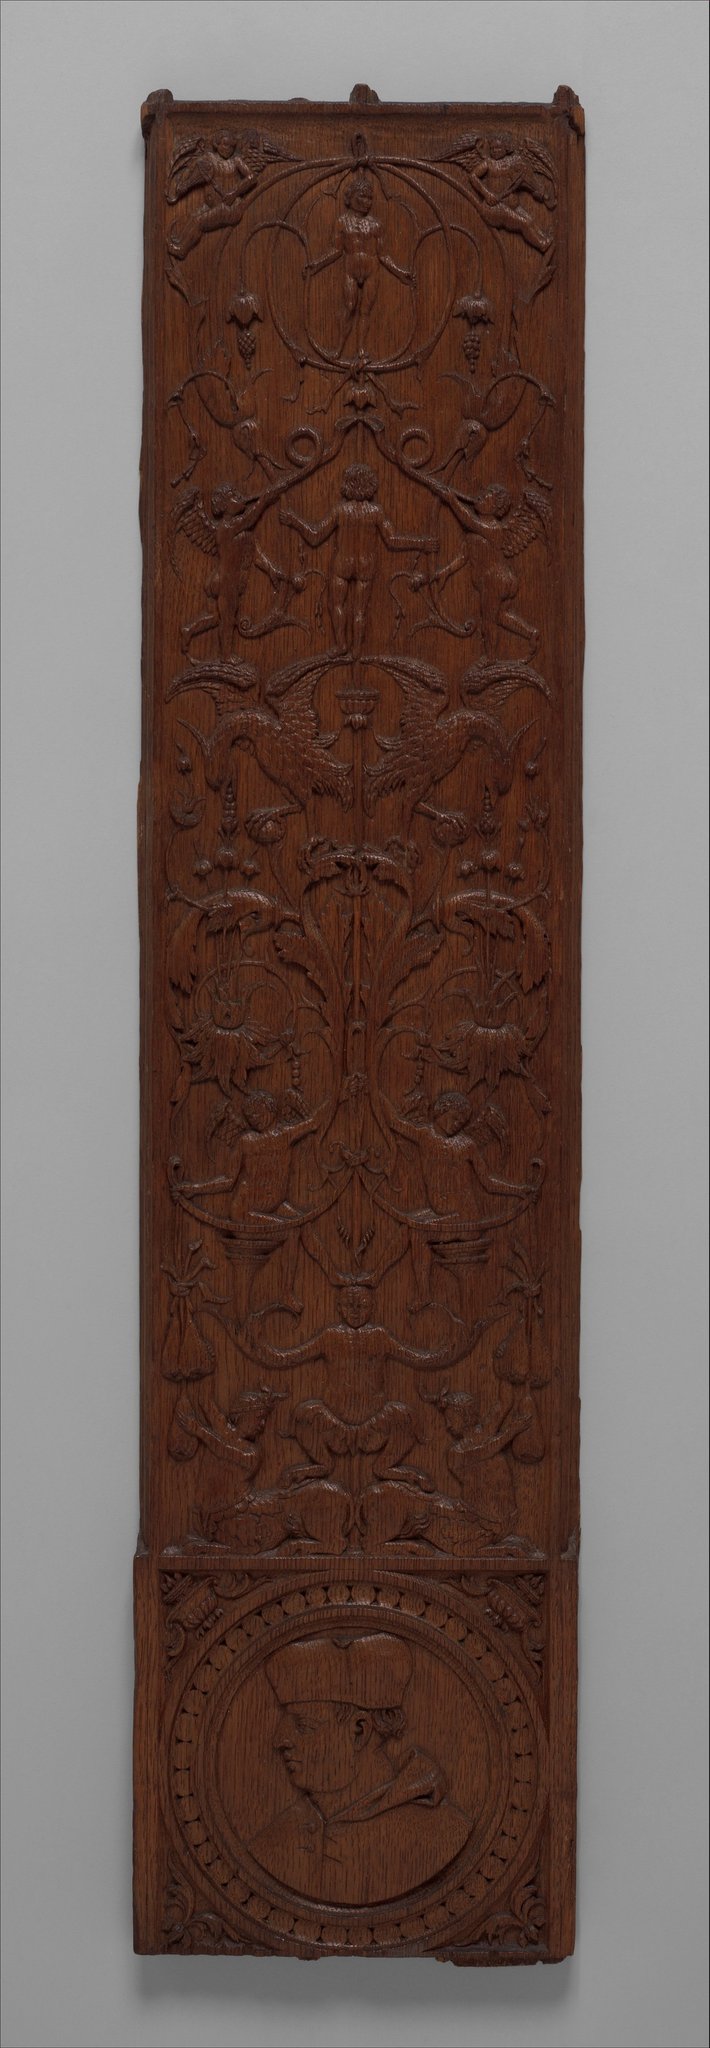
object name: choir screen panel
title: Choir screen panel (one of six)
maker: nicolas castille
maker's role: maker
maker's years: 1503-1521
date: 1508-1510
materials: wood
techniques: carving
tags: birds,men,male nudes